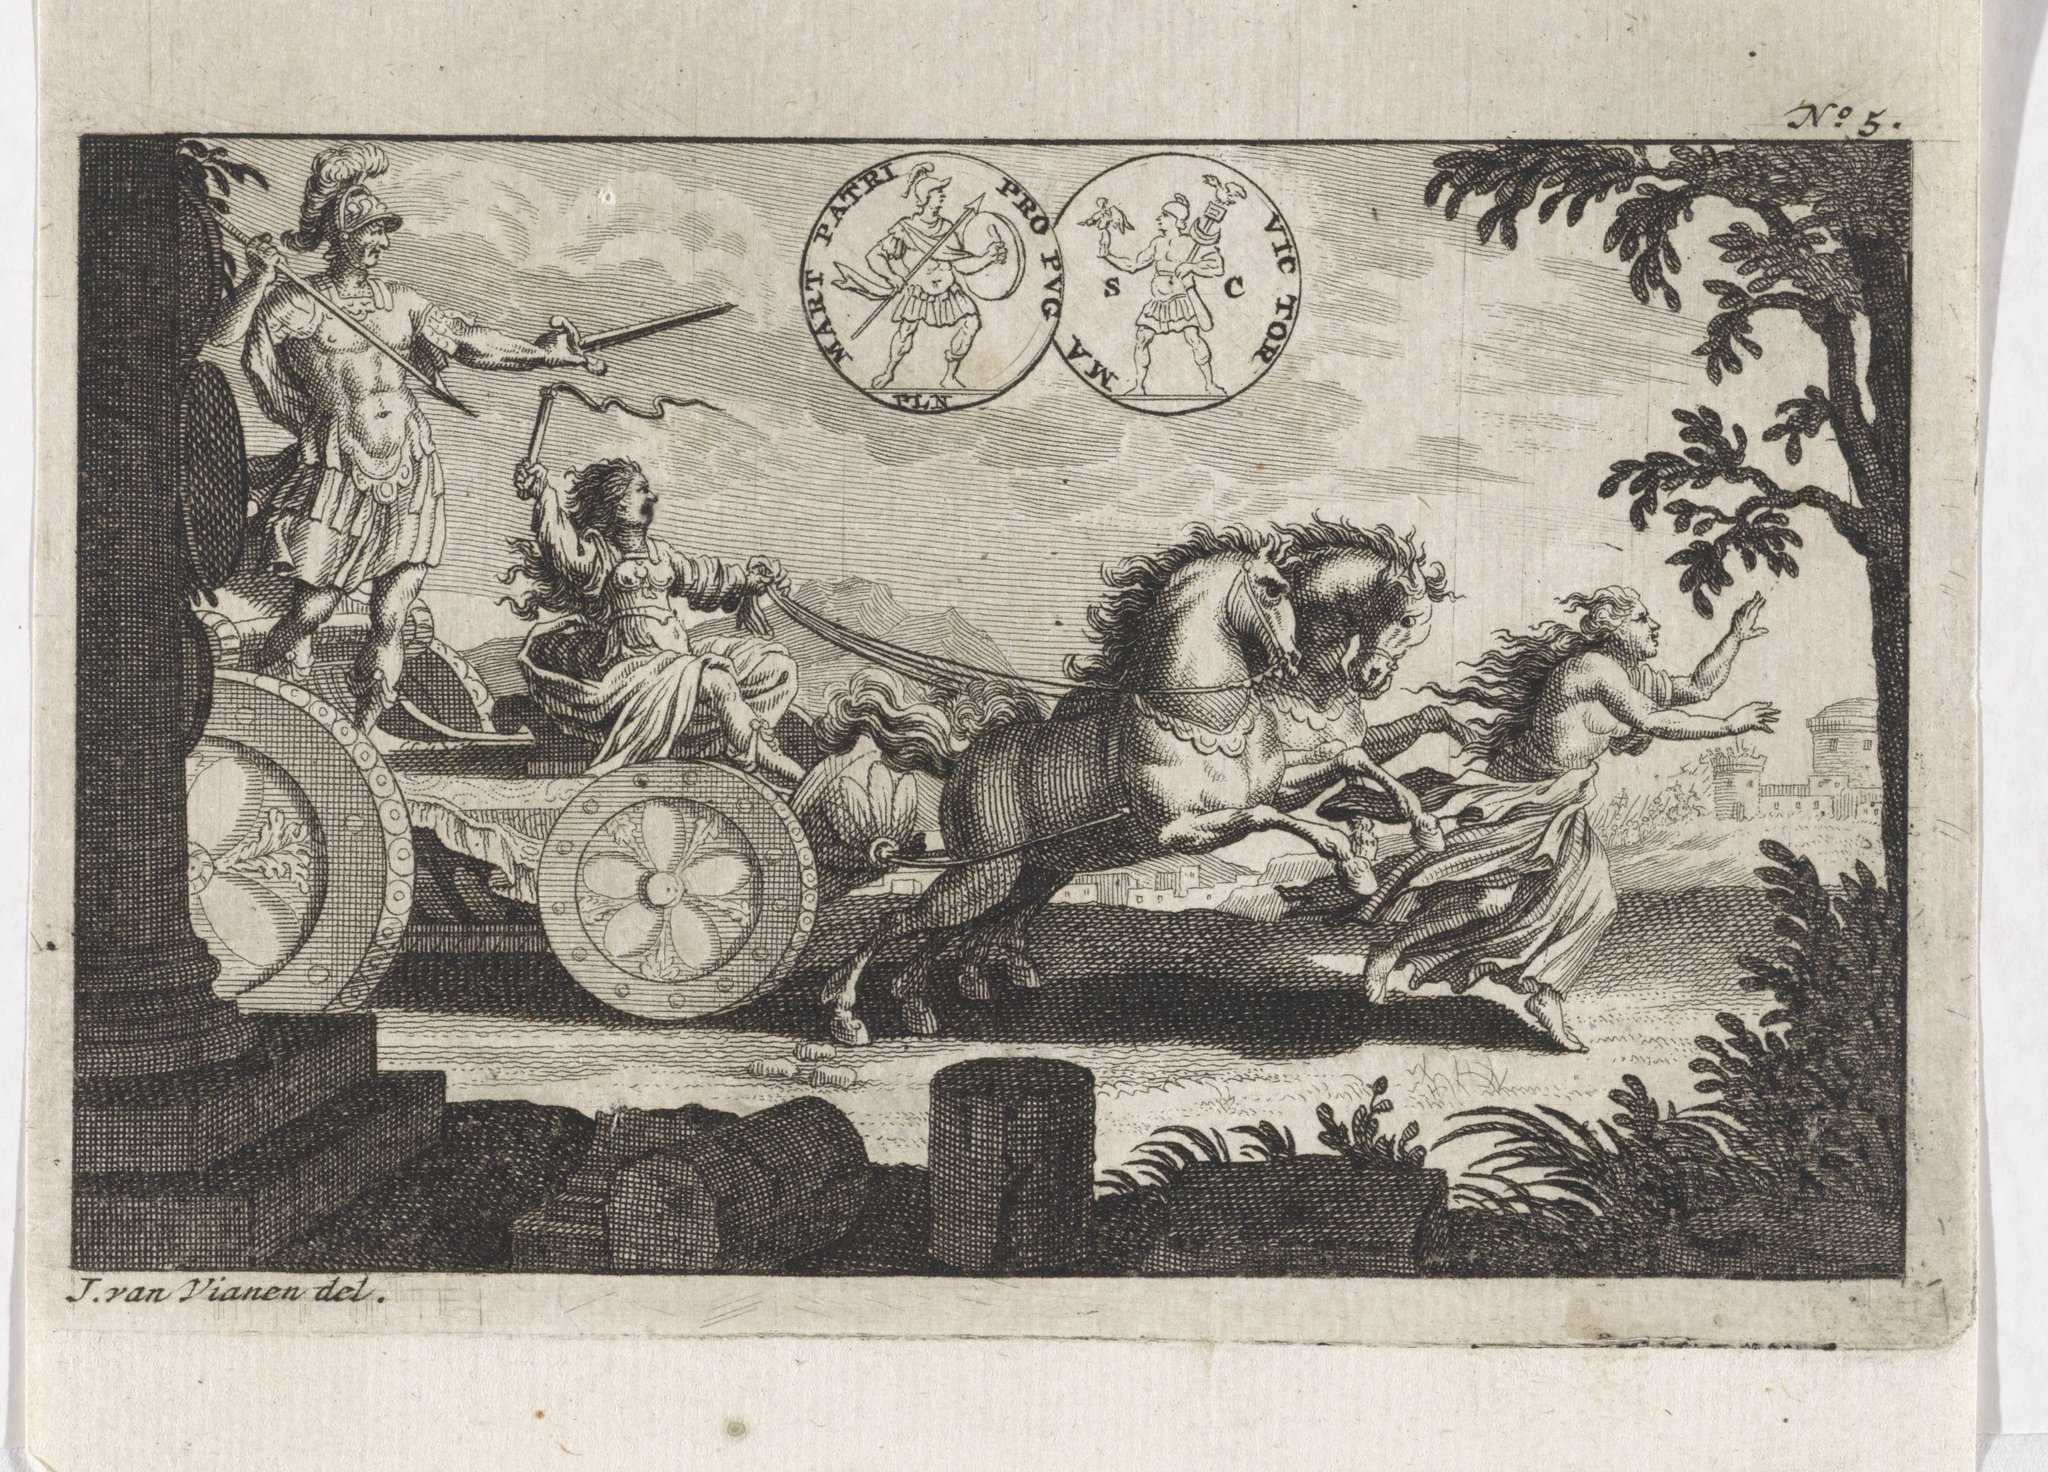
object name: print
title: Veldheer op een triomfwagen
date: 1680-1780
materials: paper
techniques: engraving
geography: low countries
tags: chariot, triumphal car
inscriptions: collector's mark: Lugt 2228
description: Een Romeinse veldheer staat op een triomfwagen, die door twee paarden wordt voortgetrokken. De paarden worden door een vrouw gemend. Een tweede vrouw rent voor de wagen uit. Vooraan enkele, deels gebroken zuilen. Boven twee medaillons met een veldheer. Rechtsboven: No. 5.